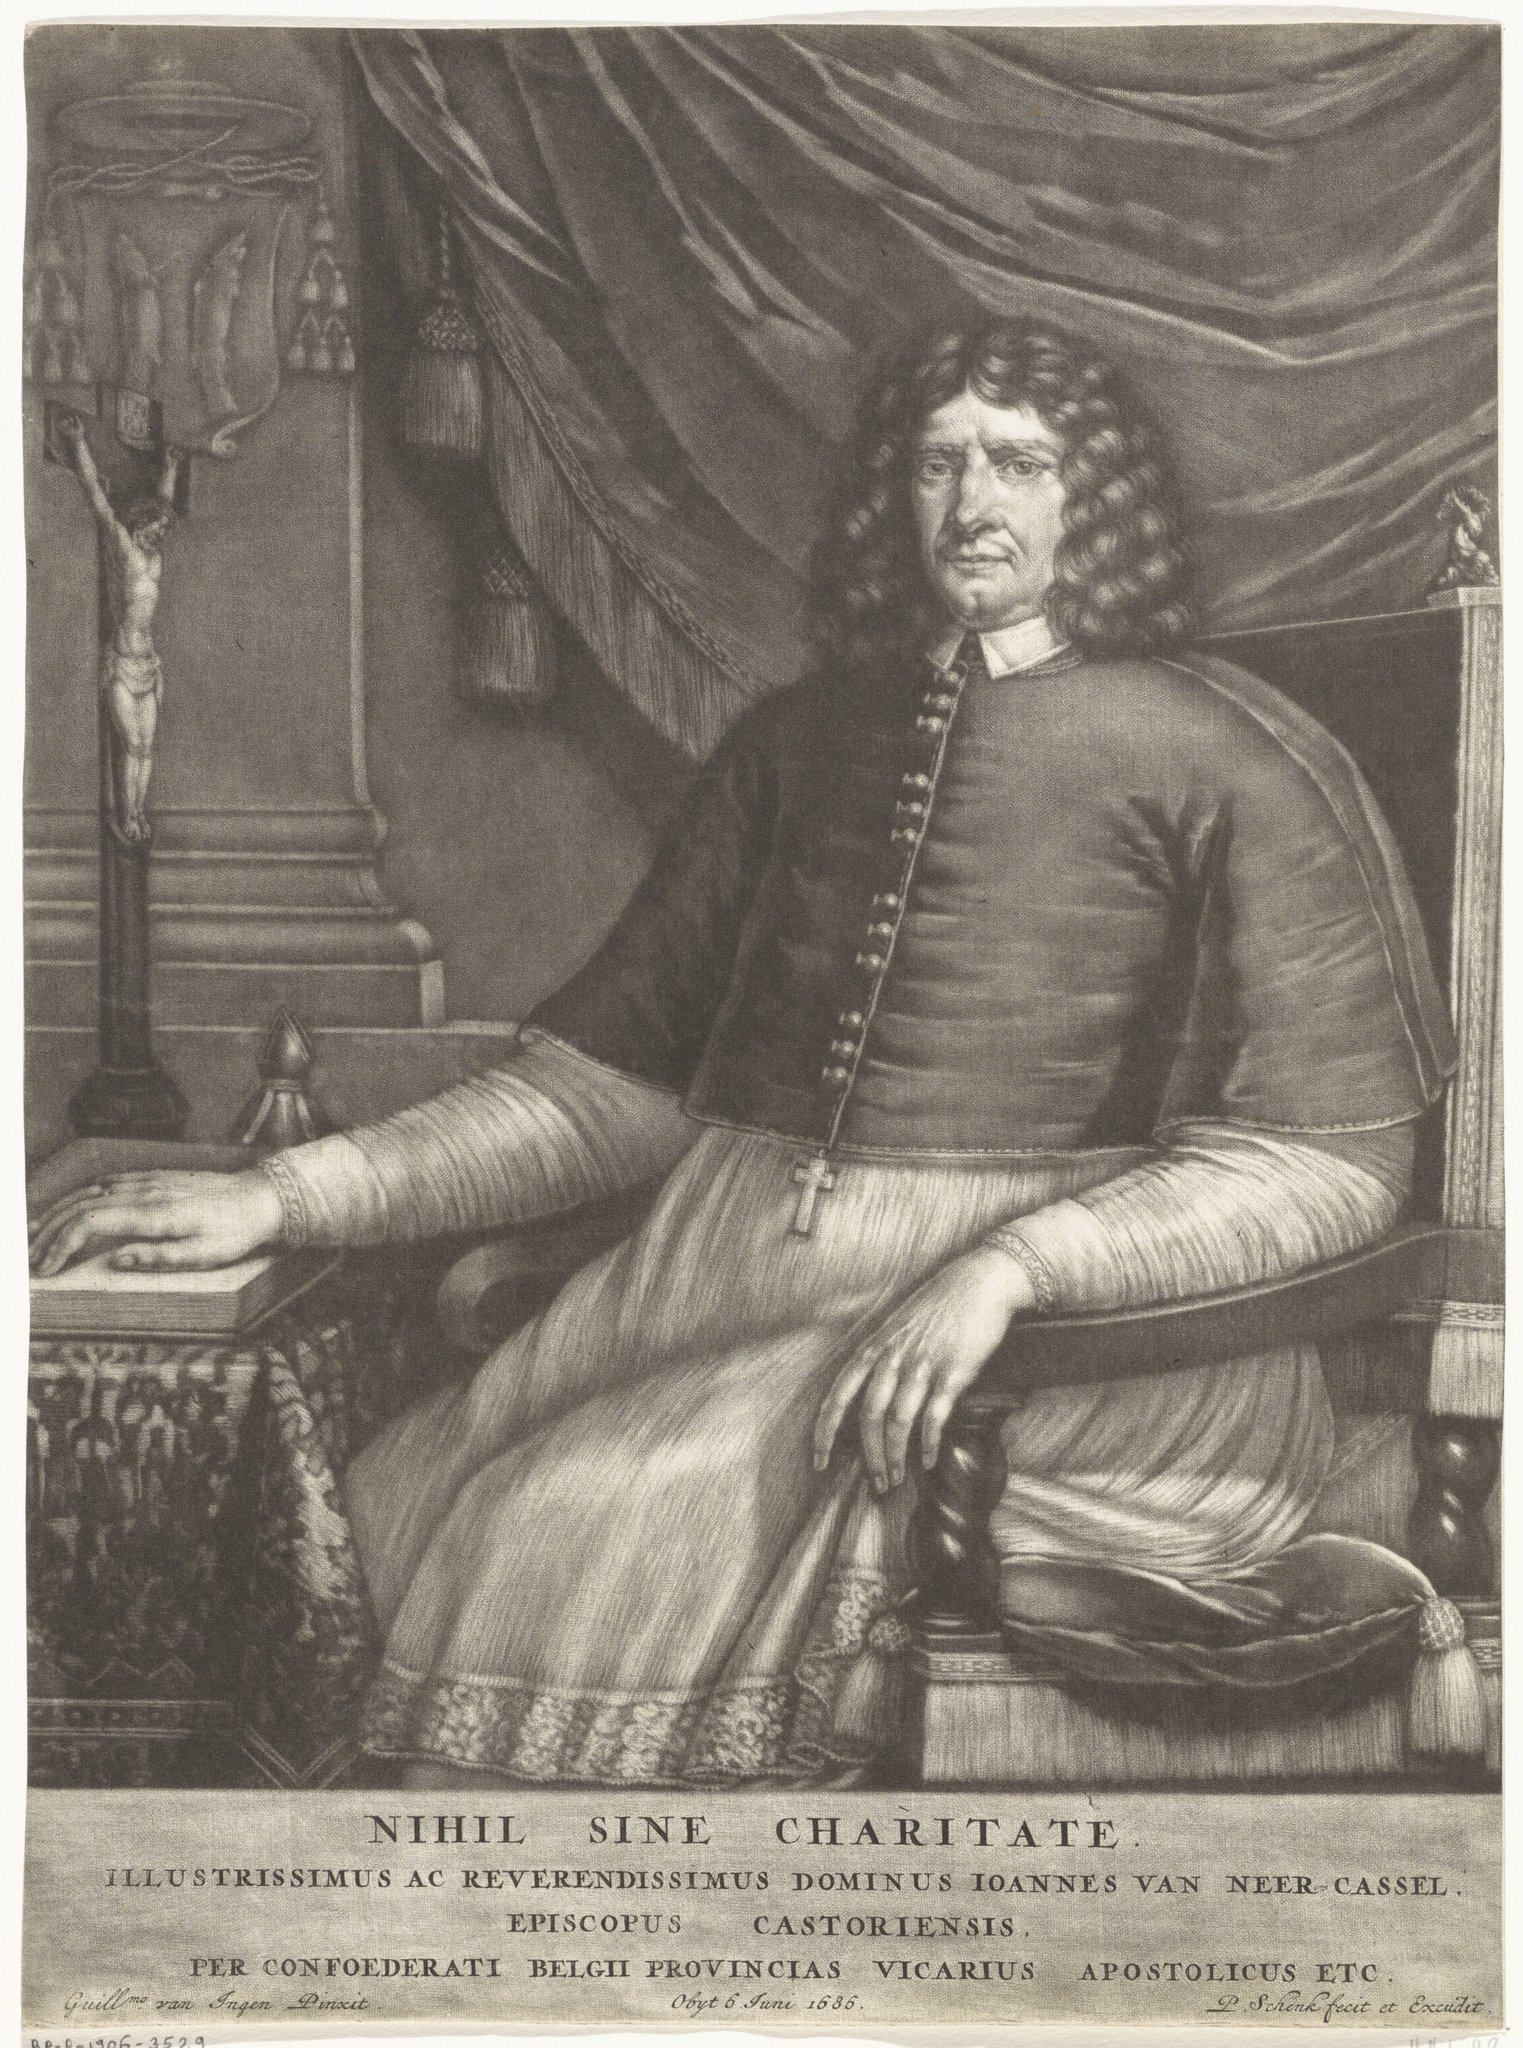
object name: print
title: Portret van Johannes van Neercassel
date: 1686-1713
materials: paper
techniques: engraving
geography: amsterdam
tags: book, crucifix ~ personal devotion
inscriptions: collector's mark: Lugt 2228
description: Johannes van Neercassel, apostolisch vicaris van de Hollandse Missie. Hij zit in een stoel en laat zijn hand op een boek rusten.